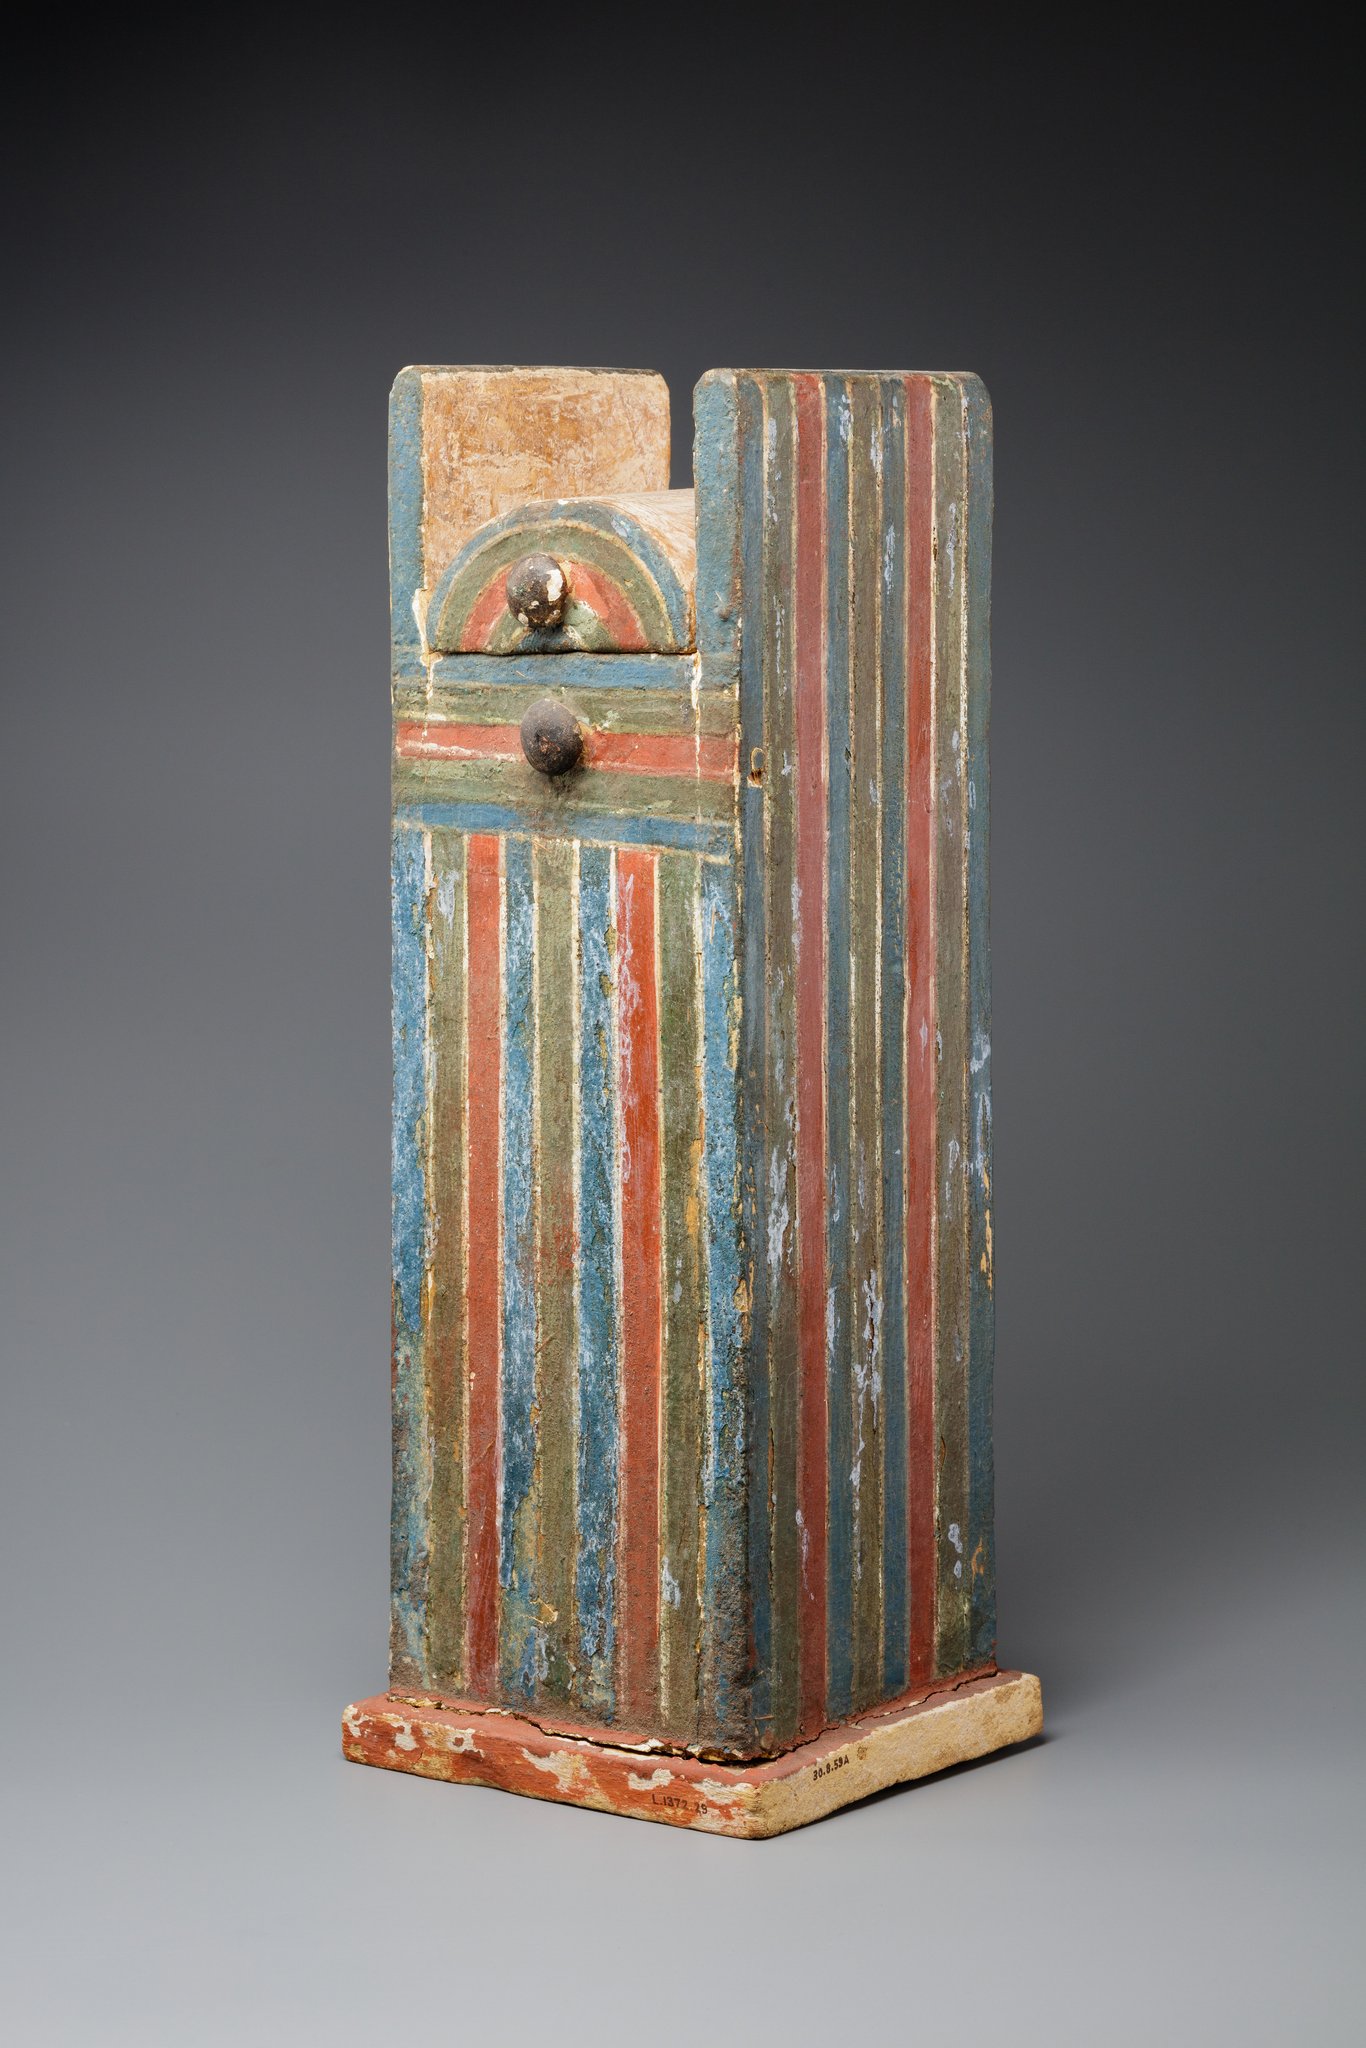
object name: shabti box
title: Shabti Box of Yuya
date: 1390-1352 BCE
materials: paint, wood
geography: egypt